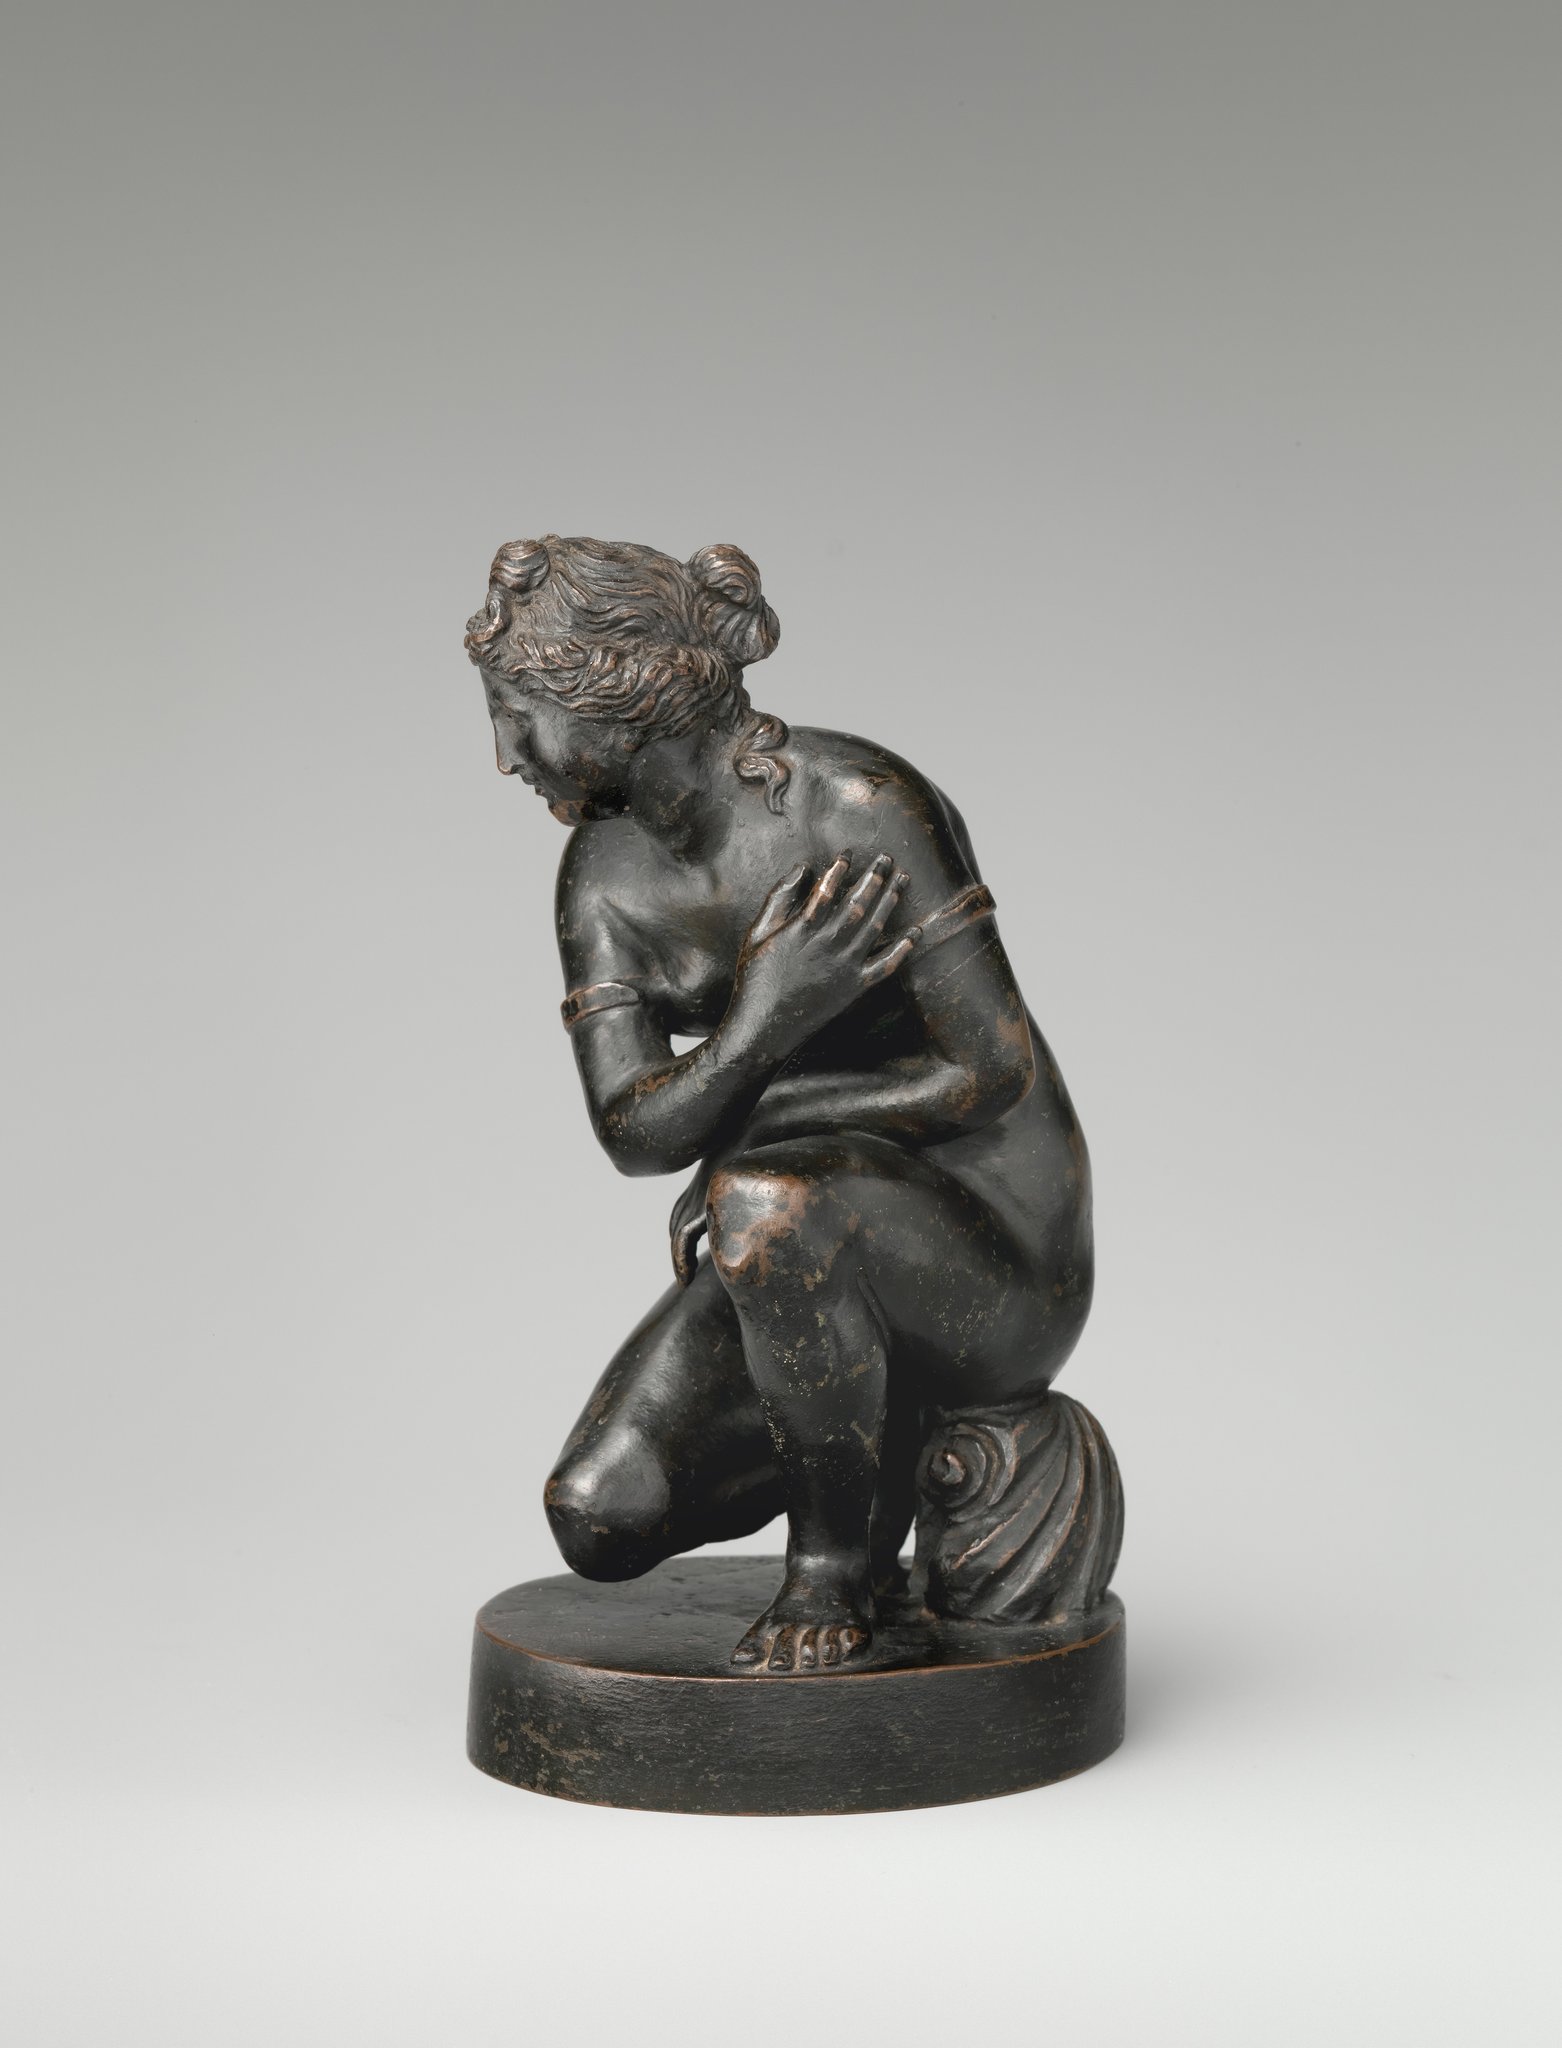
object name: statuette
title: Crouching Venus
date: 1667-1733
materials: bronze, lacquer, patina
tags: aphrodite